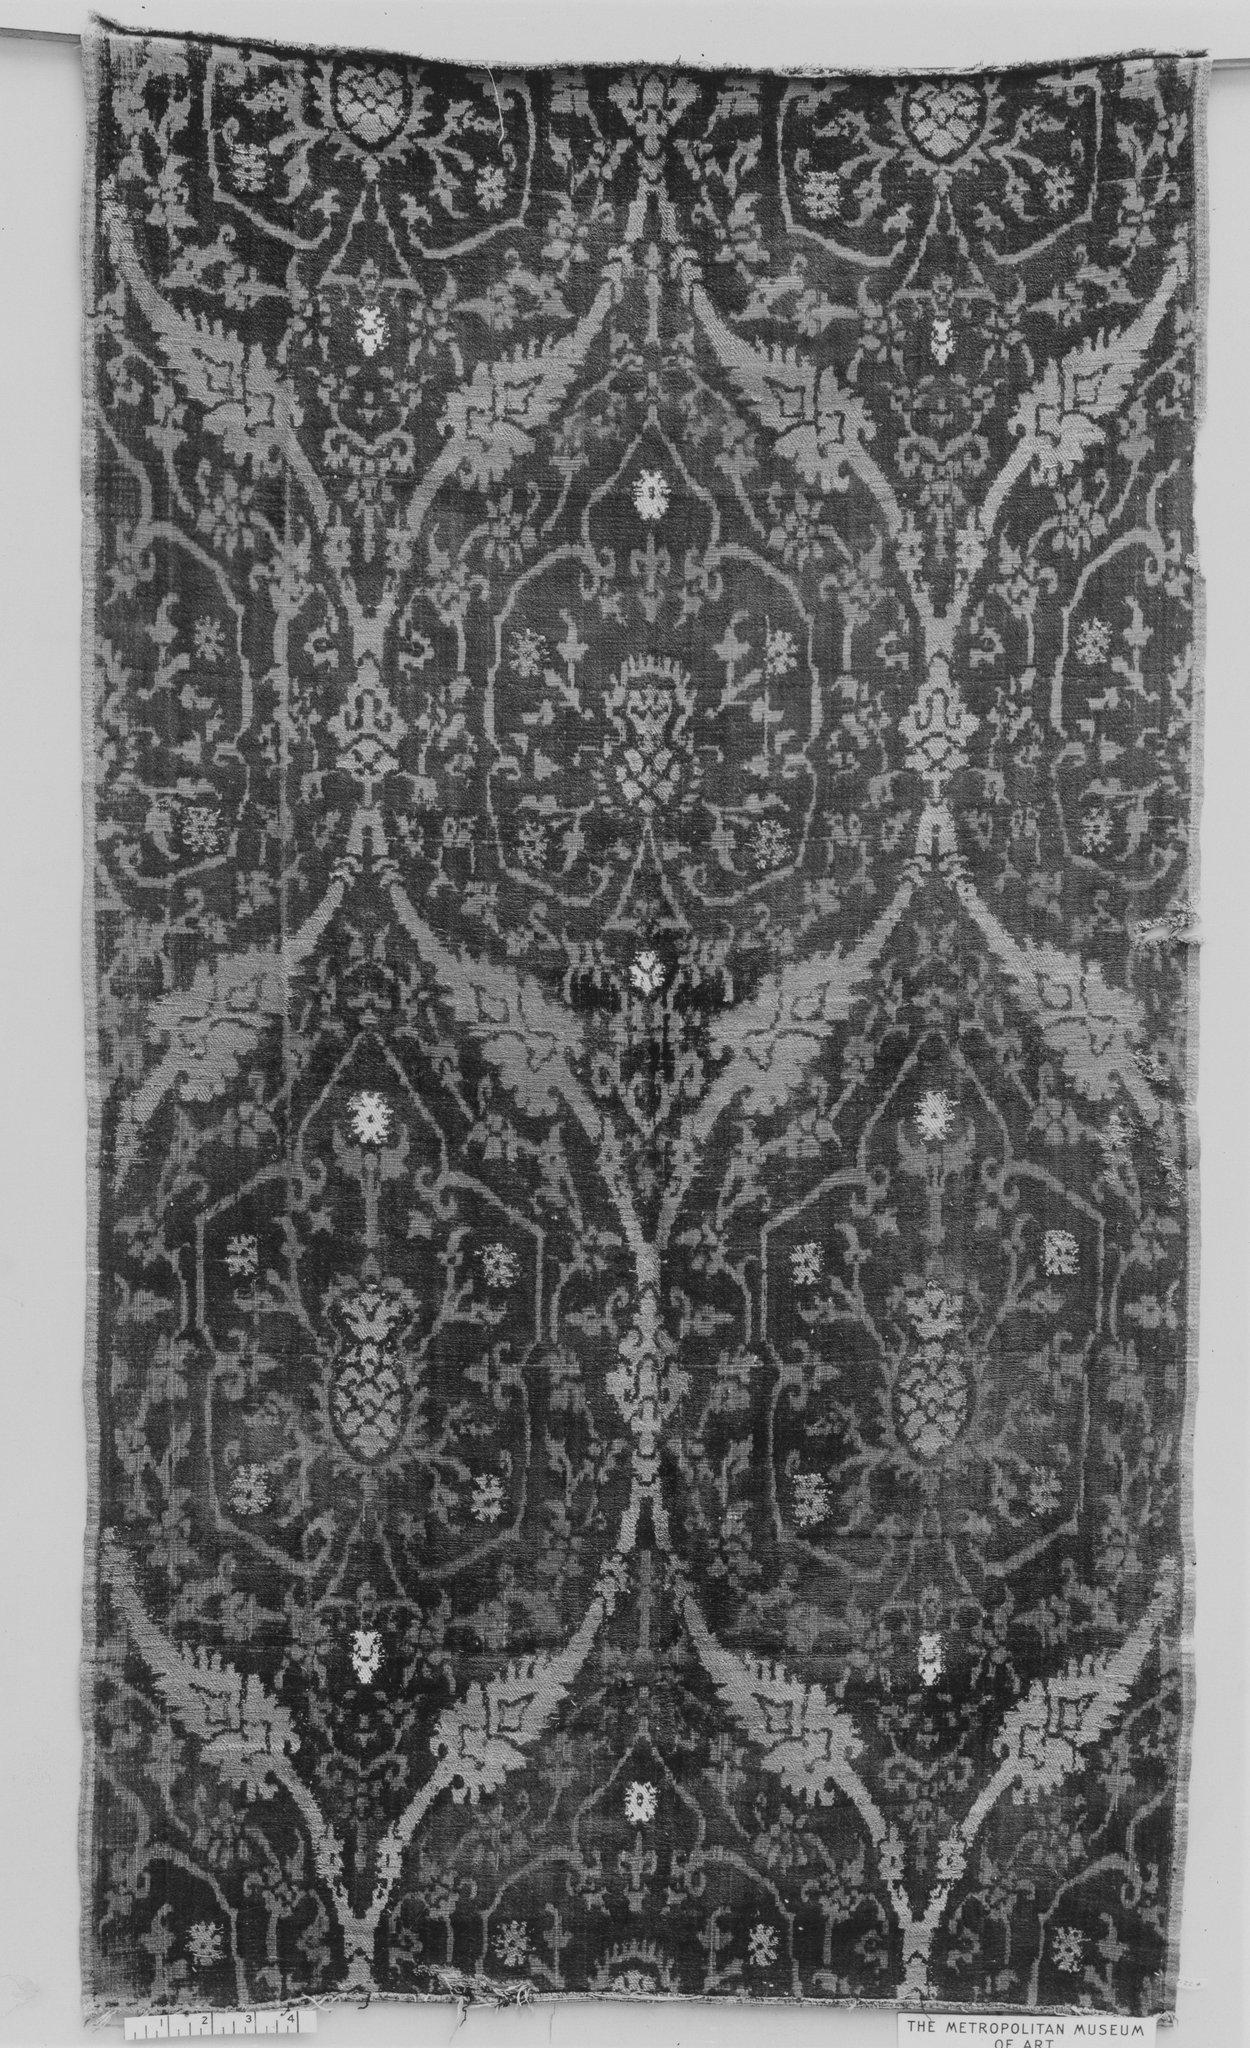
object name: panel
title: Textile Panel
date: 1701-1800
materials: silk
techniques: brocade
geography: turkey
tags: flowers